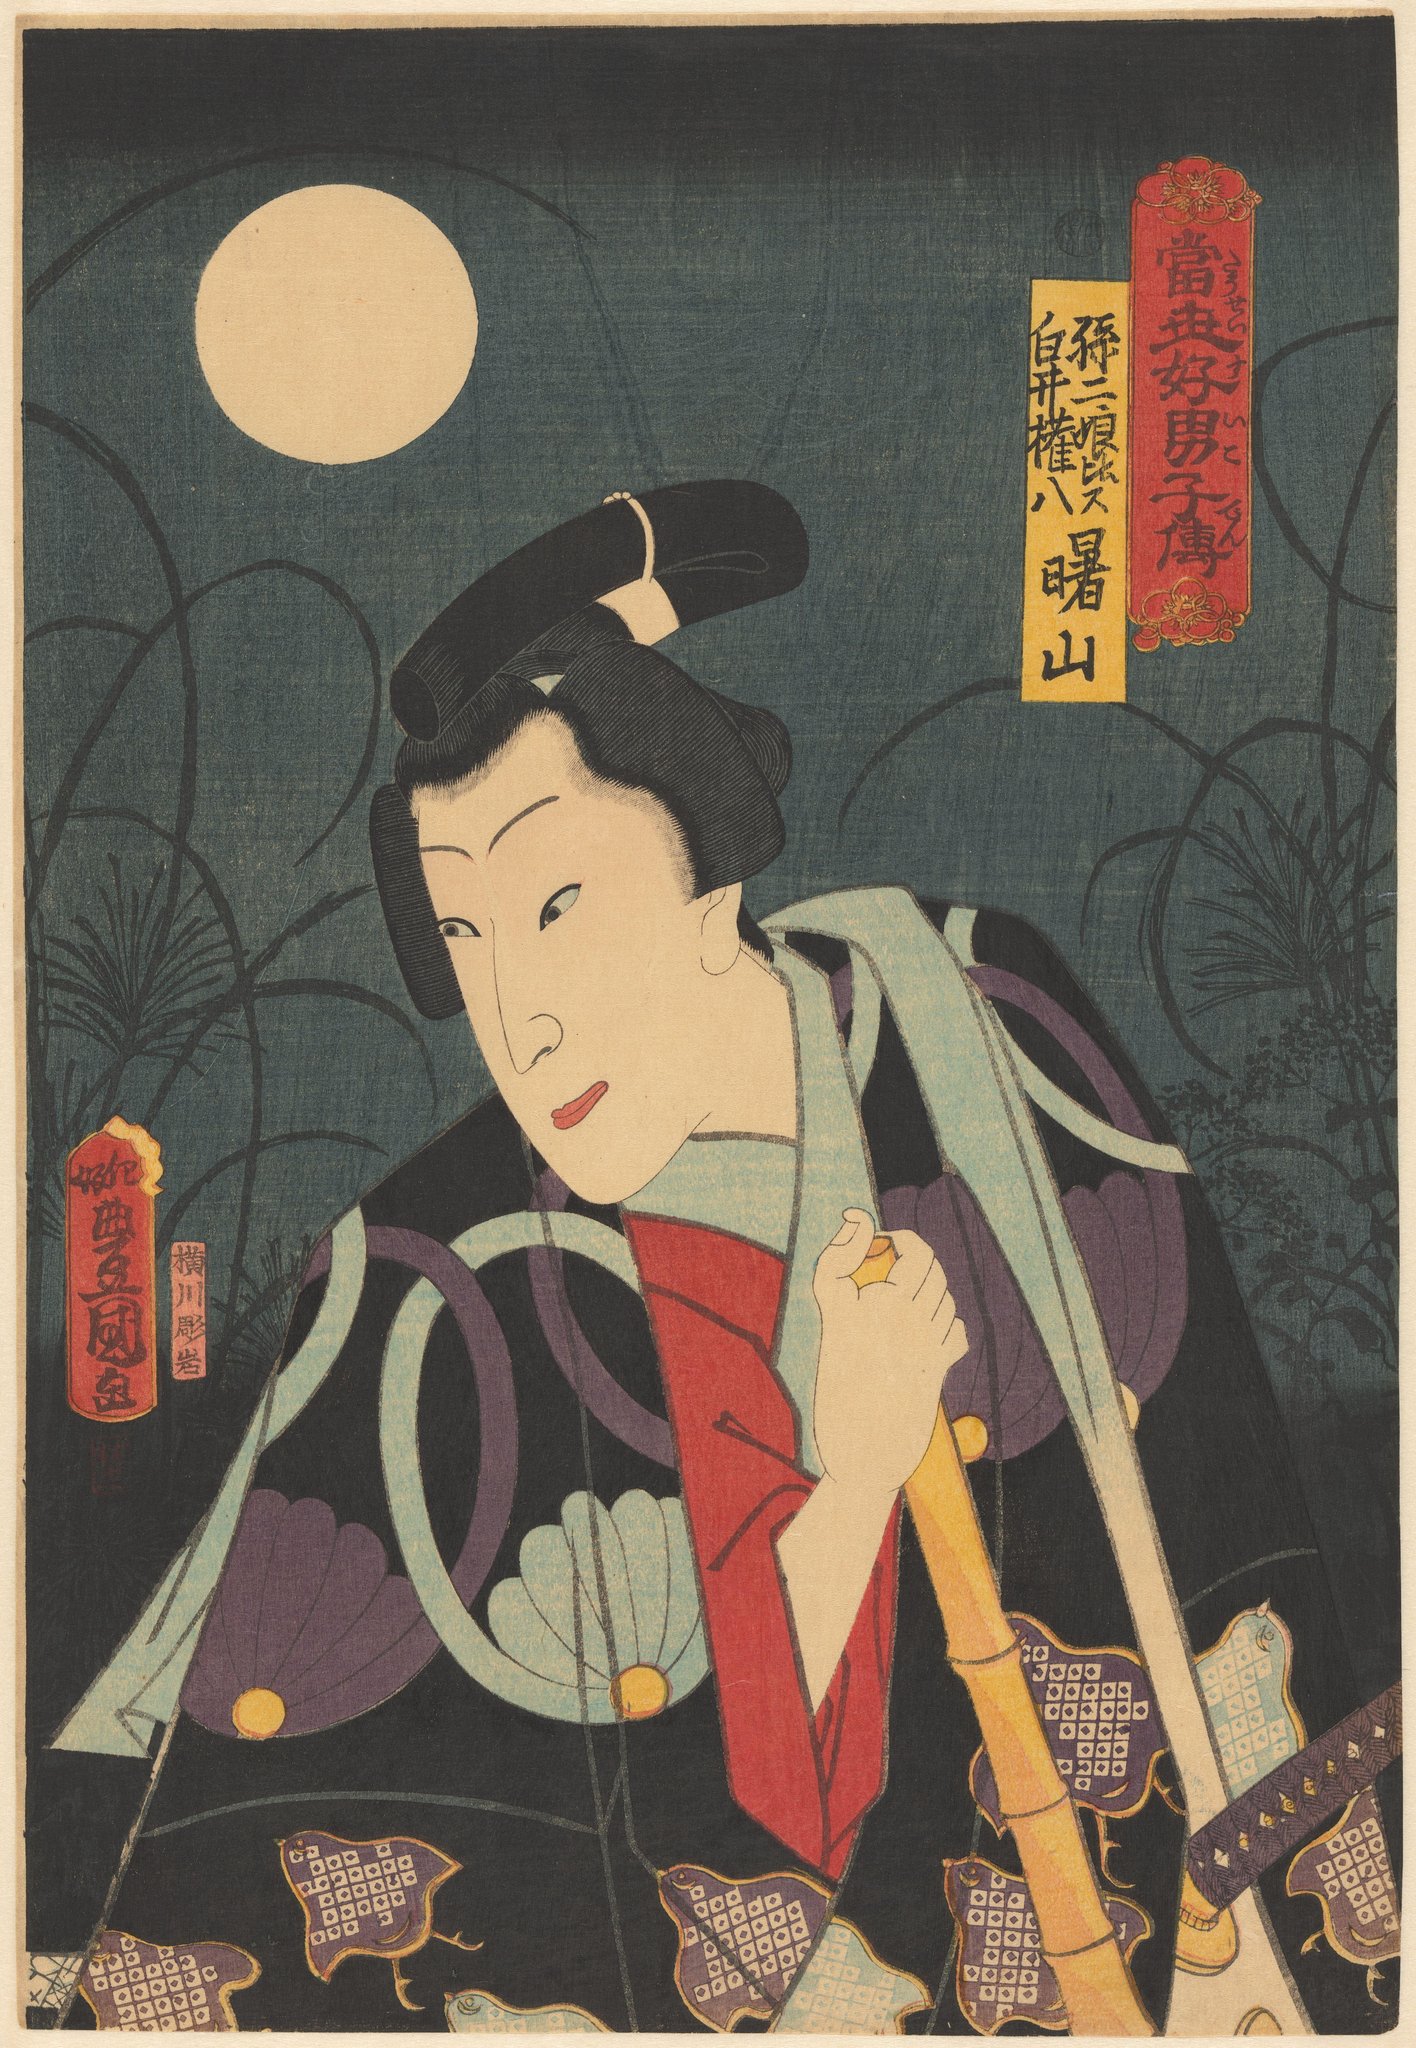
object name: print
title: Shirai Gonpachi under full moon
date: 1809-1861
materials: paper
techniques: woodcut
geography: japan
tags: full moon, actor (on the stage), flute, aulos, tibia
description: Kabuki acteur Sawamura Tanosuke III in de rol van Shirai Gonpachi, met bamboe fluit in zijn hand. Nachtelijke scene bij volle maan en met bamboe gras op de achtergrond.